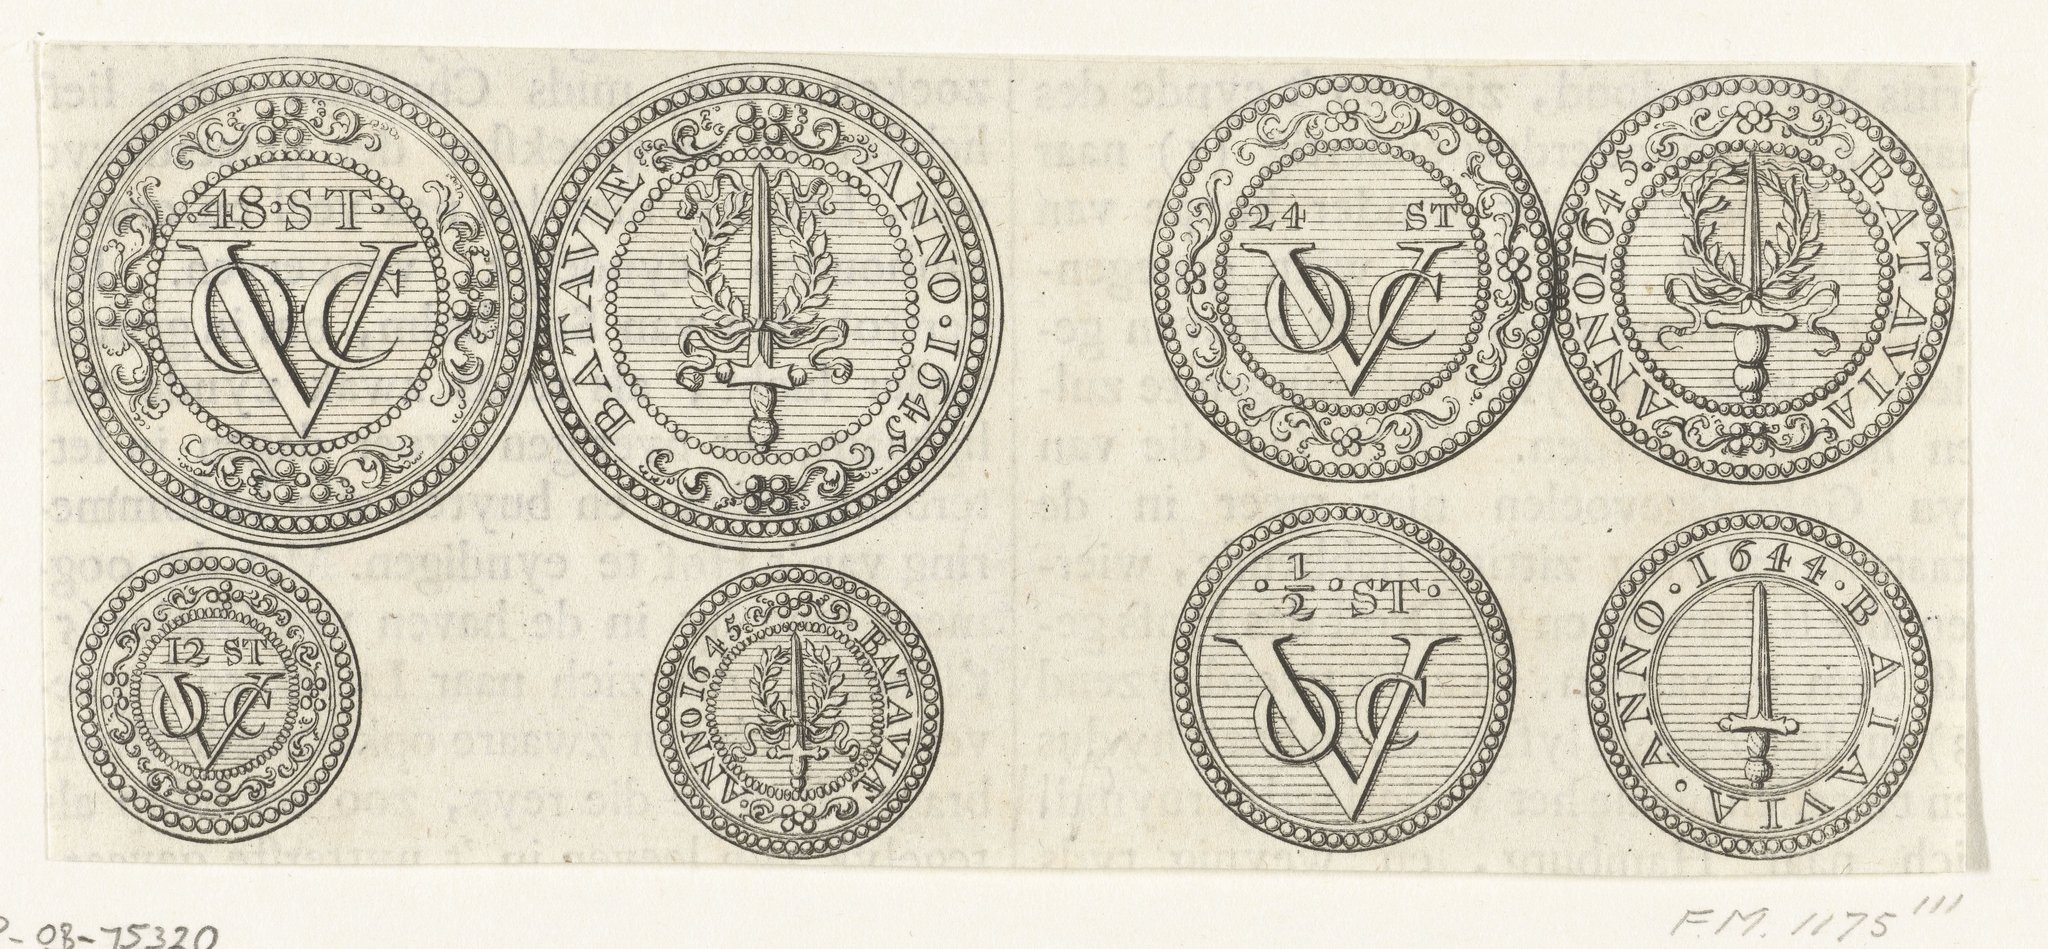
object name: historical object representation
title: Vier munten van de VOC, 1644-1645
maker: Anonymous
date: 1700-1799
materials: paper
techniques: etching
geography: netherlands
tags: trade token, private coin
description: Vier munten in omloop gebracht door de VOC, 1644-1645. Op achterzijde bedrukt met tekst in het Nederlands.